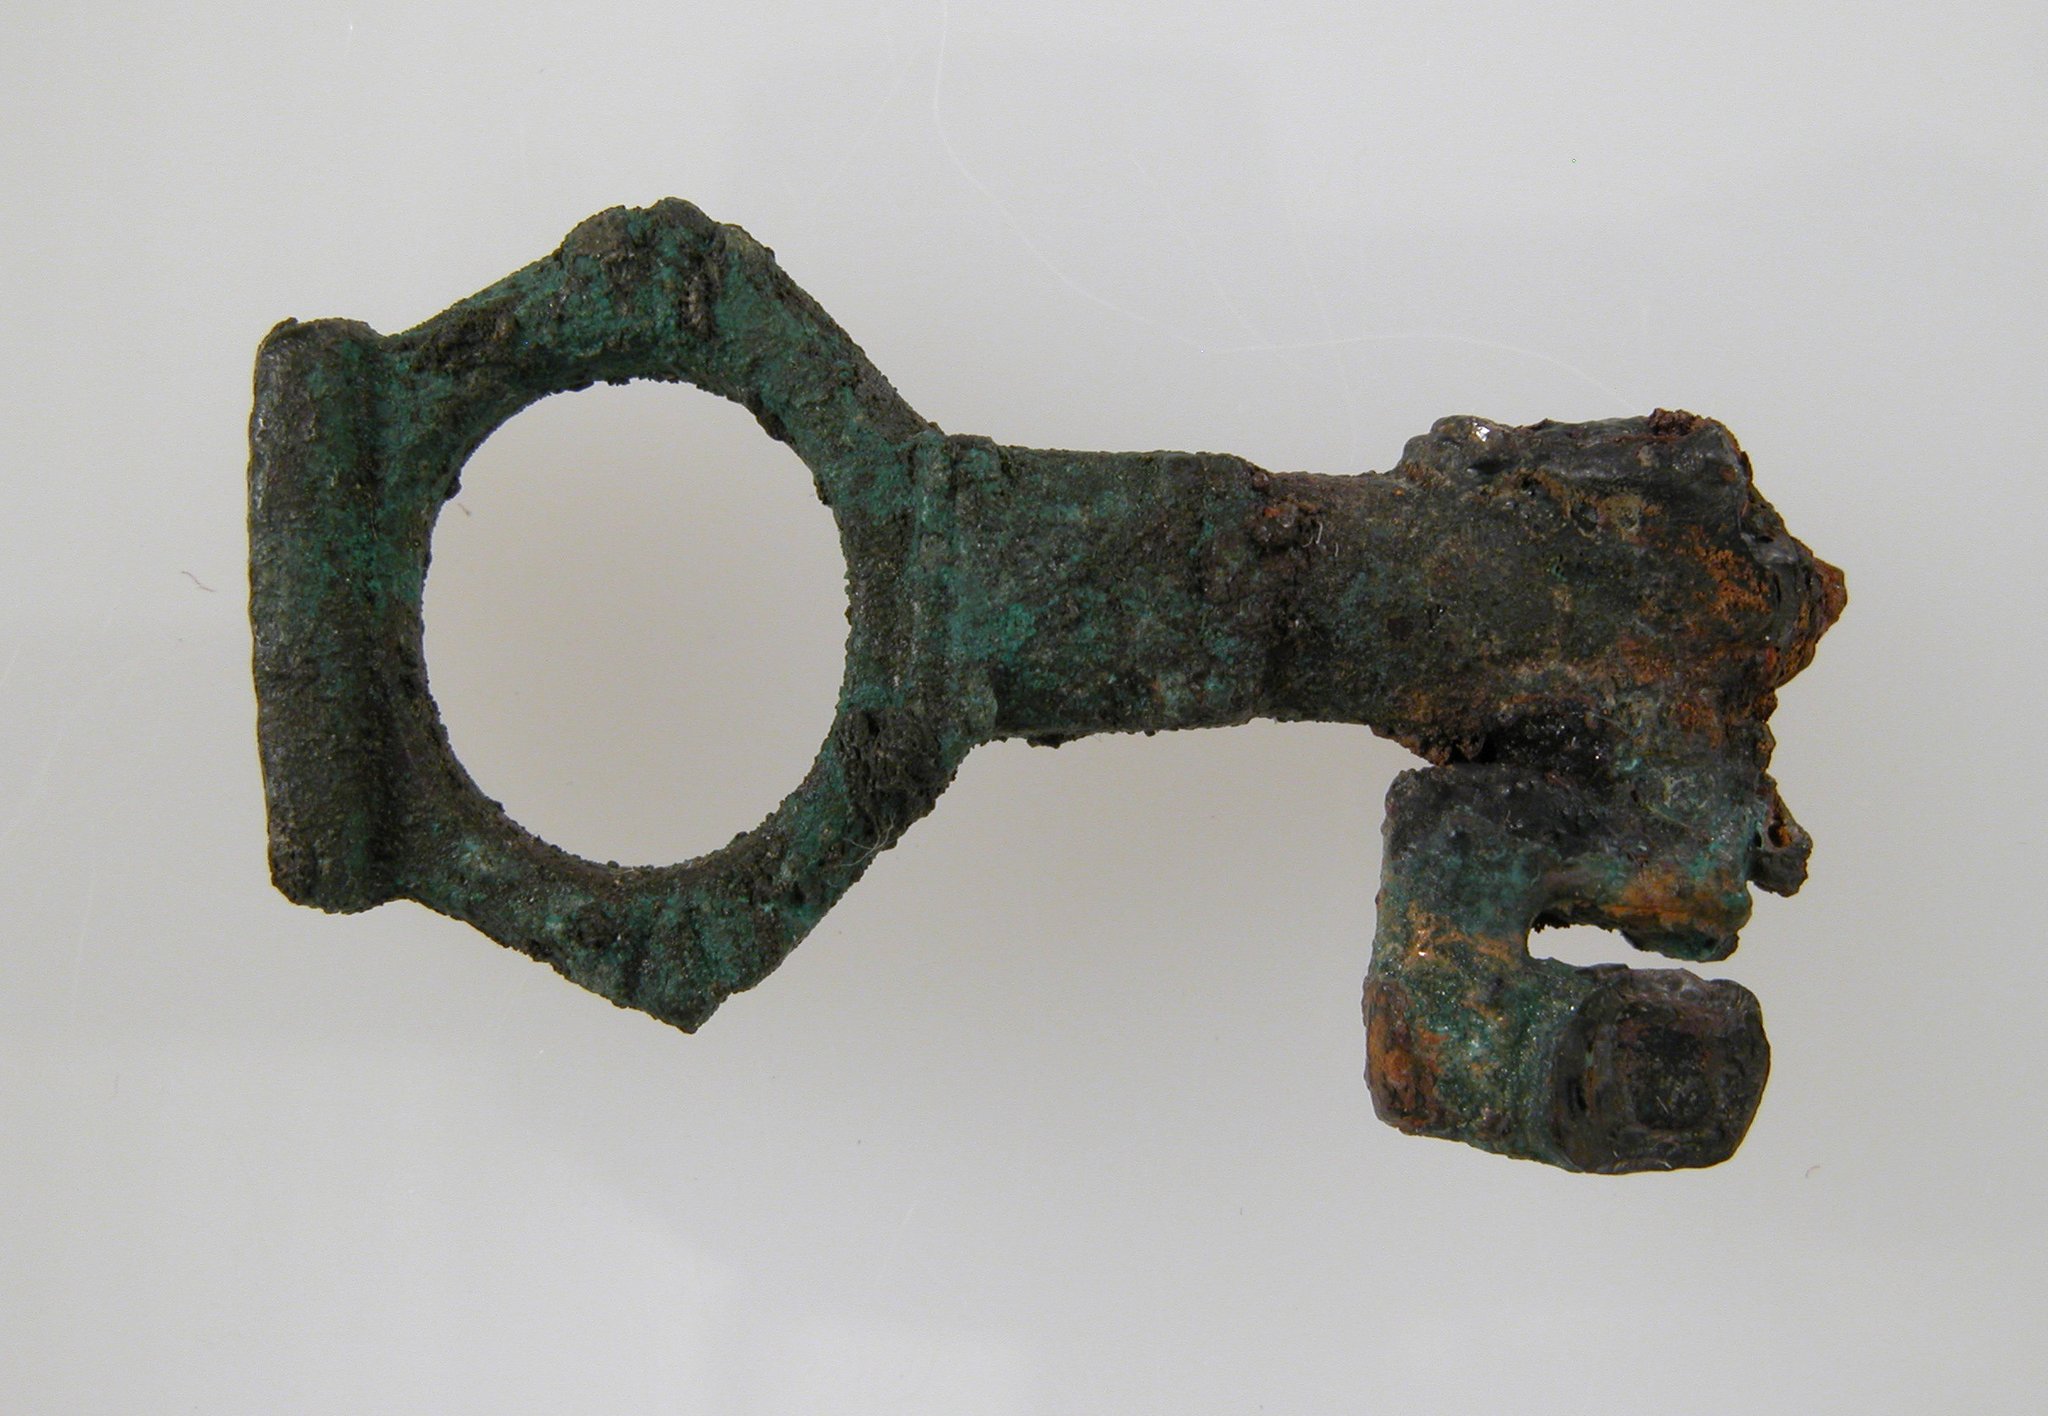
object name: key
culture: frankish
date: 601-700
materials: copper alloy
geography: niederbreisig